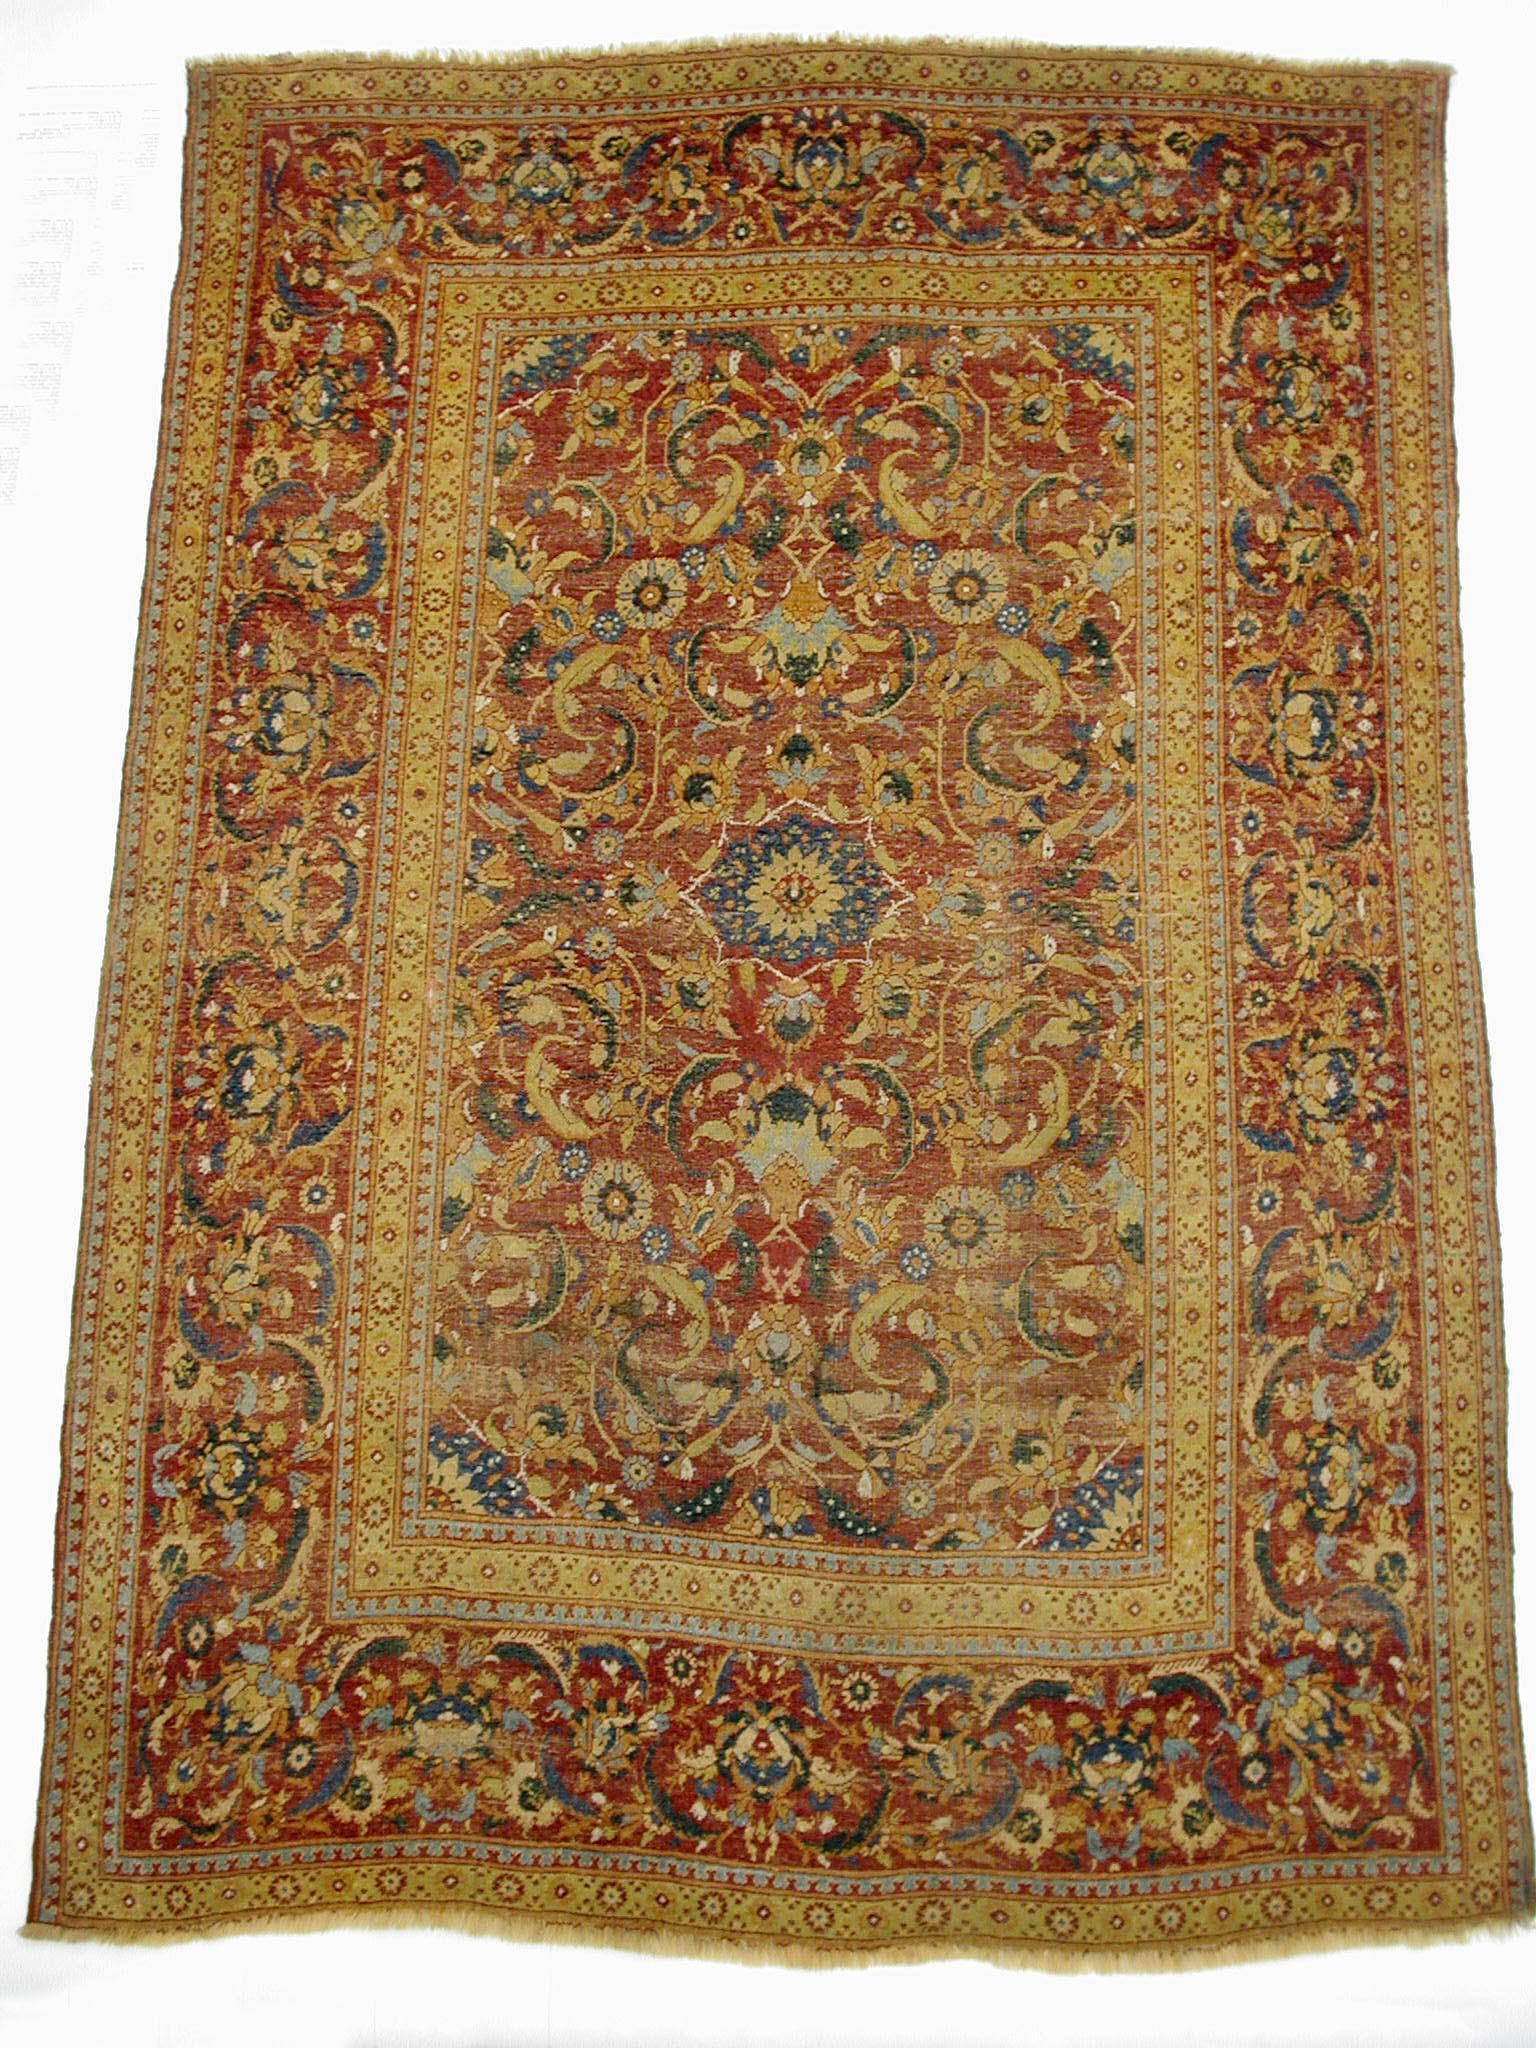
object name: carpet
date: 1601-1700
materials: wool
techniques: asymmetrically knotted pile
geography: egypt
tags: flowers